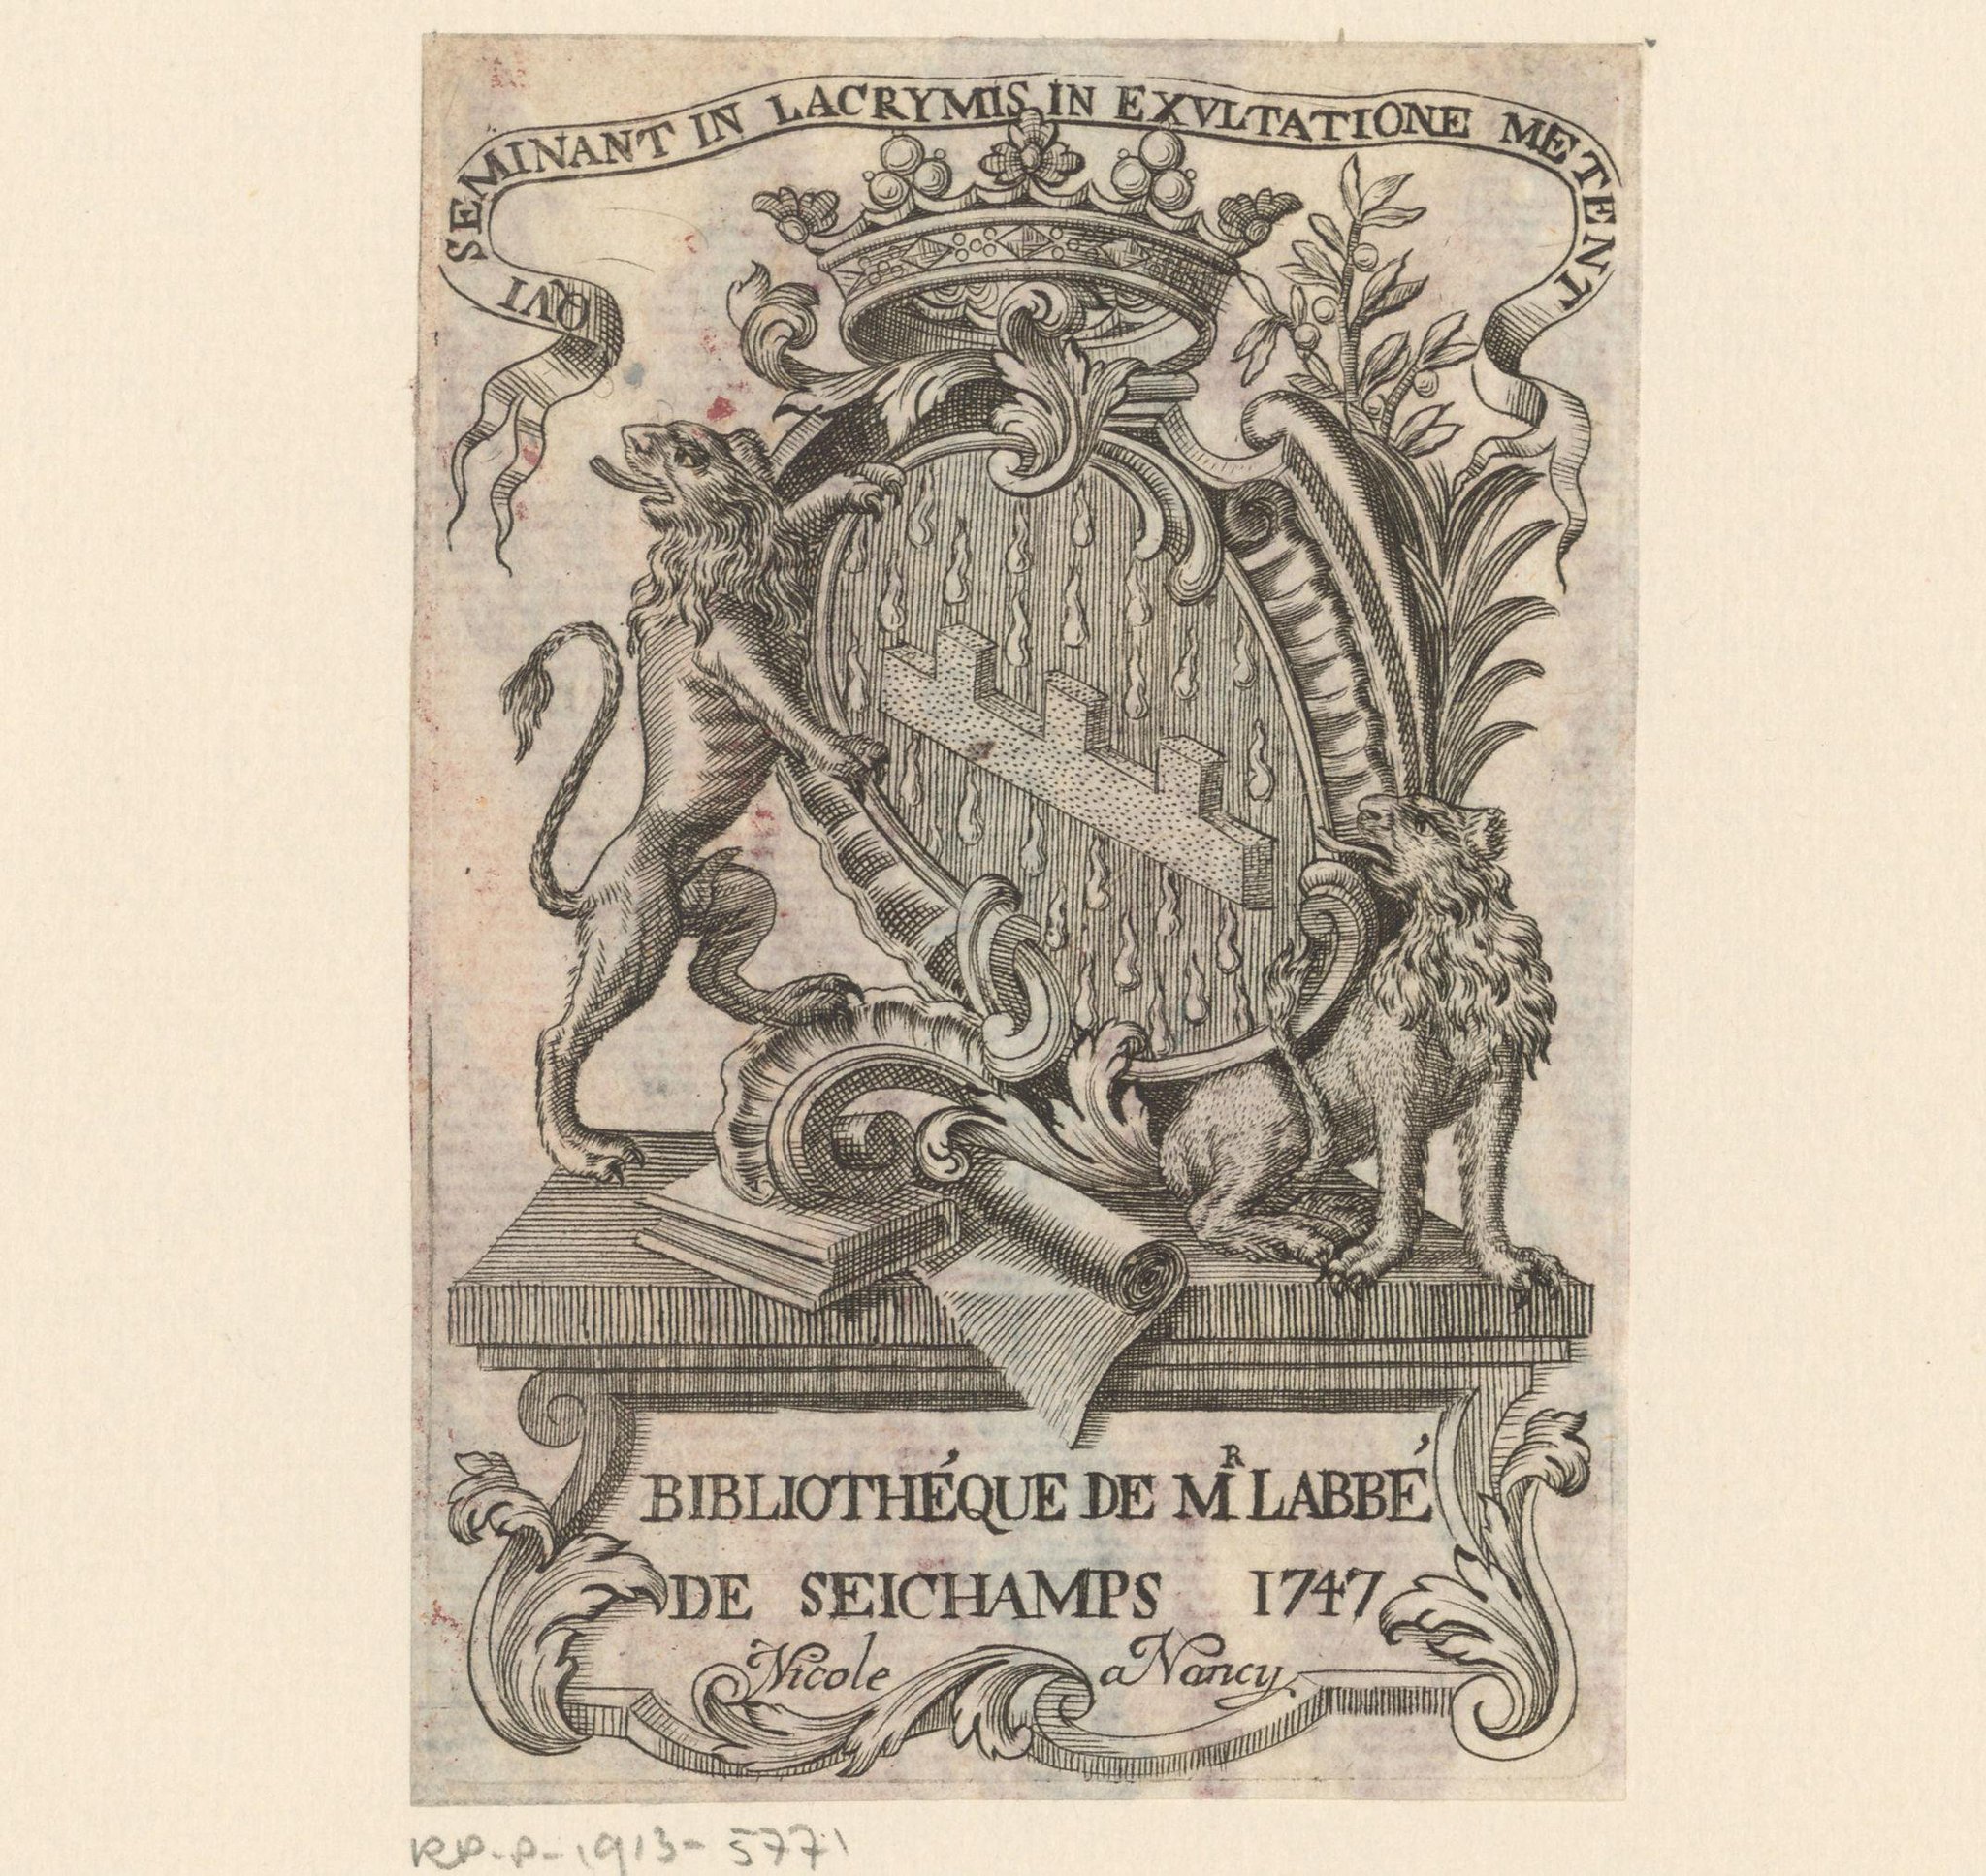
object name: bookplate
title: Bibliothèque de mr. Labbé de Seichamps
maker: Anonymous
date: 1747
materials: paper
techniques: engraving, etching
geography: nancy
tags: book, beasts of prey, predatory animals: lion, armorial bearing, heraldry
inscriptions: collector's mark: Lugt 2760, collector's mark: Lugt 2233